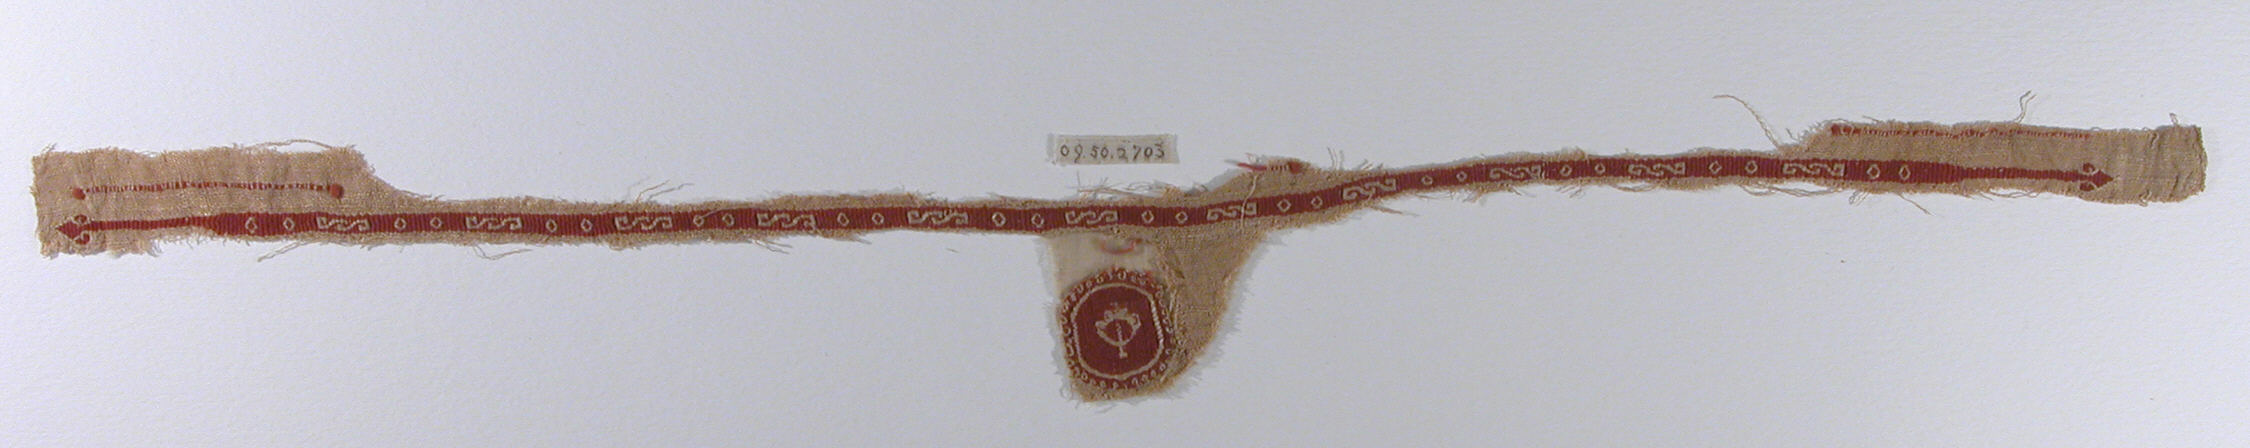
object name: shoulder band fragment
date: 401-500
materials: linen, wool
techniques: weave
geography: egypt